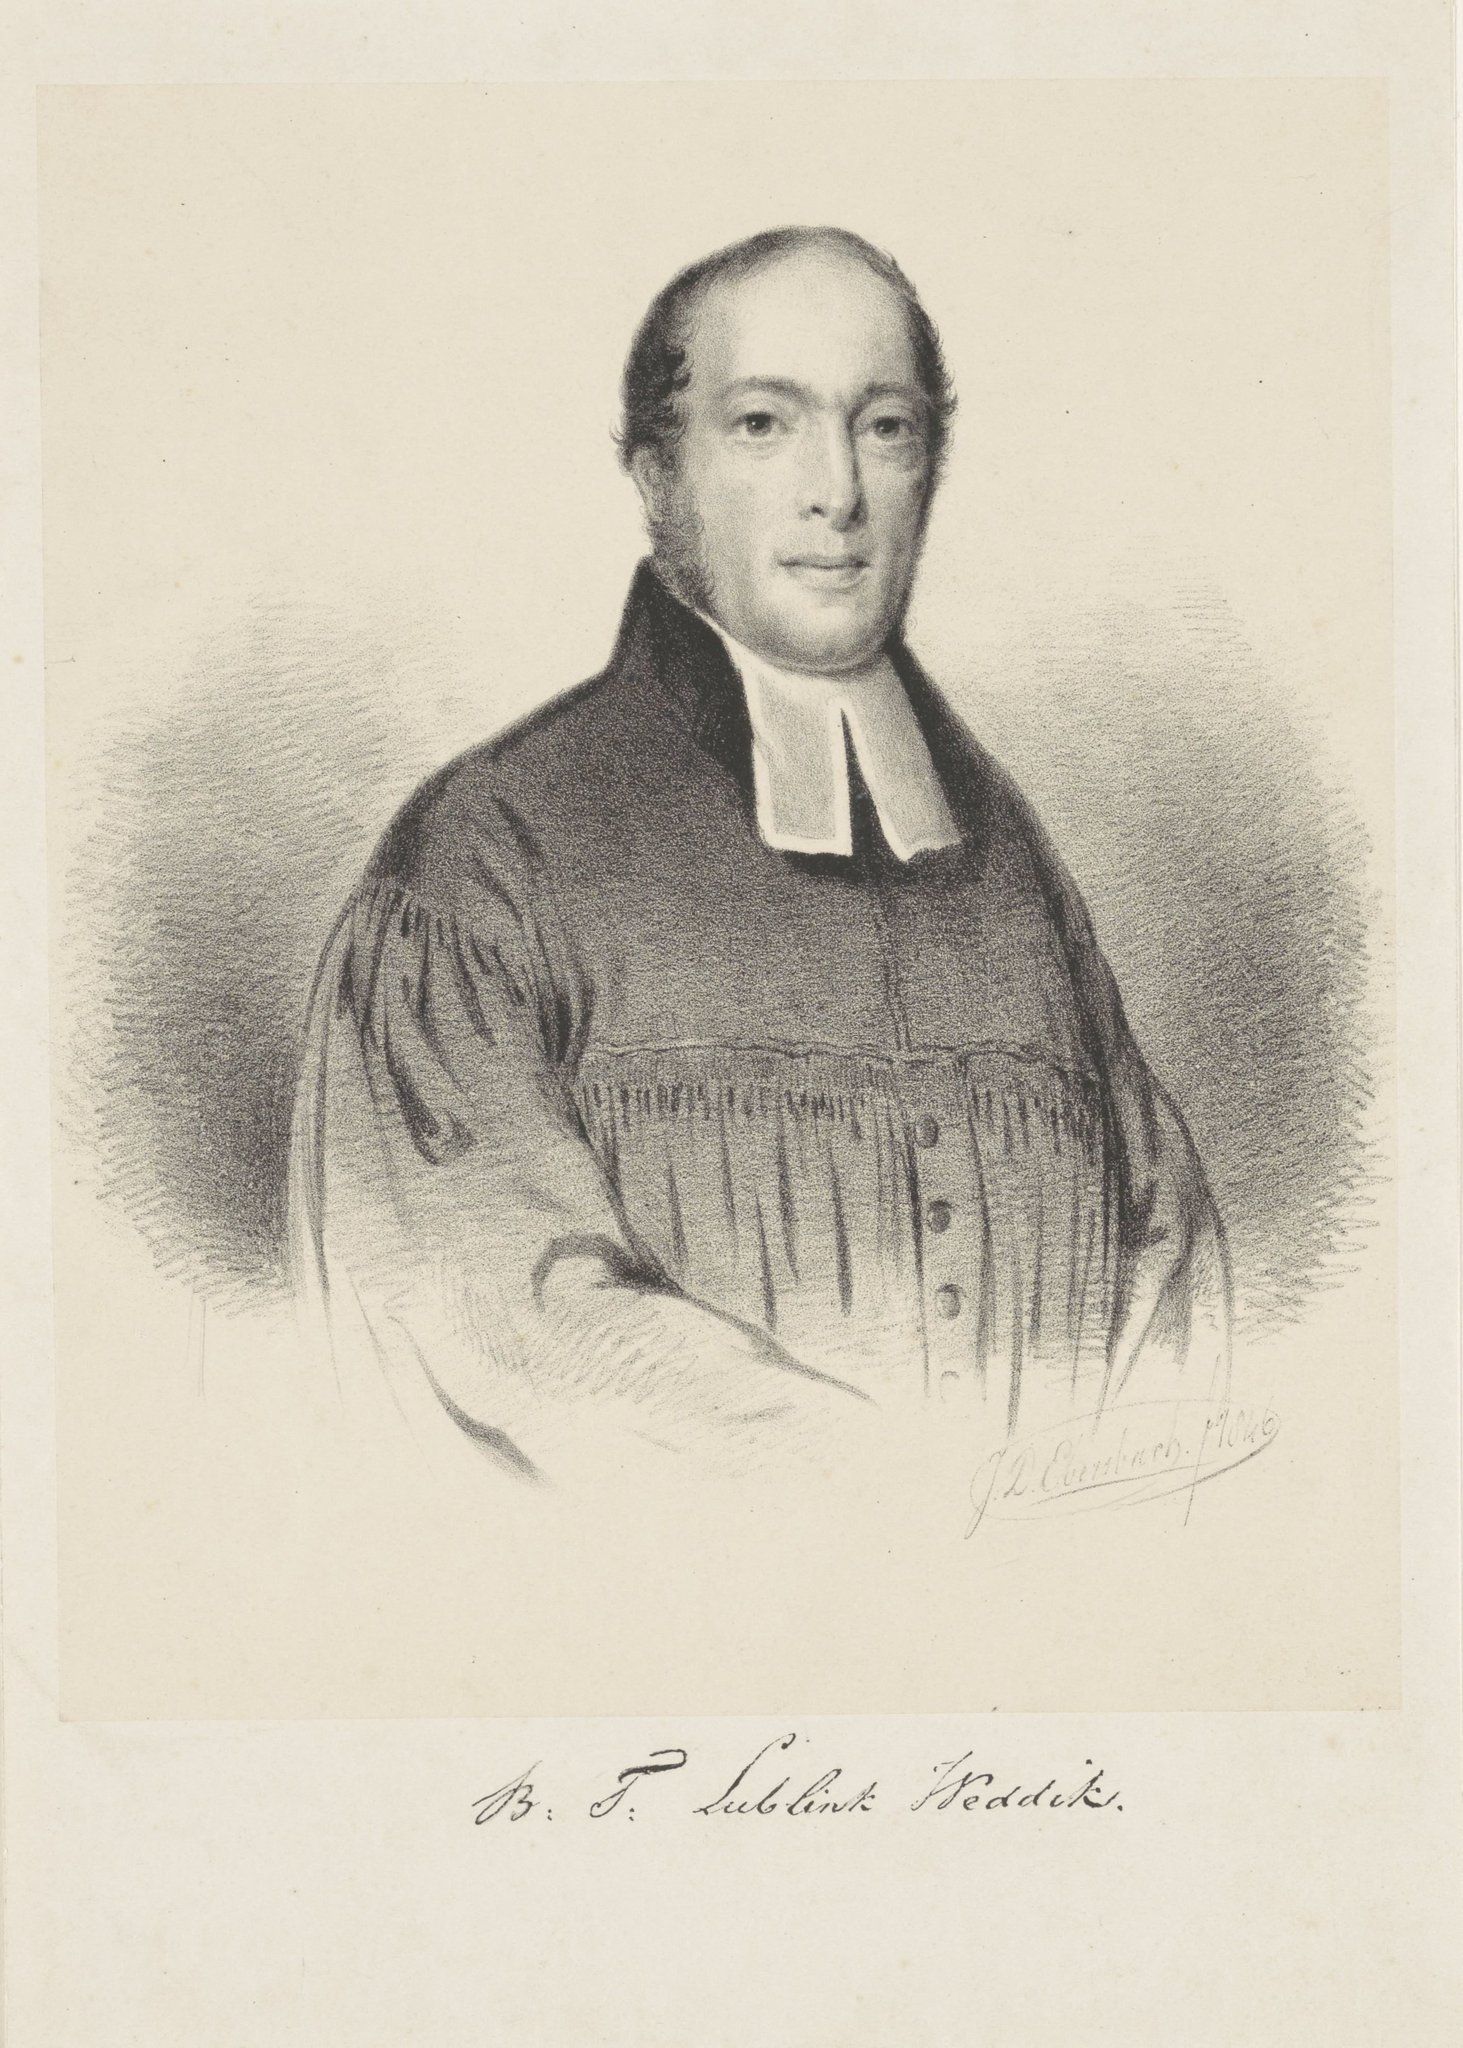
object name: print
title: Portret van Bartholomeus Theodus Lublink Weddik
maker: johan daniel ebersbach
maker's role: print maker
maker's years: 1822-1900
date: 1846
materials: paper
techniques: lithograph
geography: netherlands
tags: historical persons (+ (full) bust portrait)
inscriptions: collector's mark: Lugt 2228, collector's mark: Lugt 2760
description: De geportretteerde draagt een toga en een bef. Onder het portret zijn signatuur.